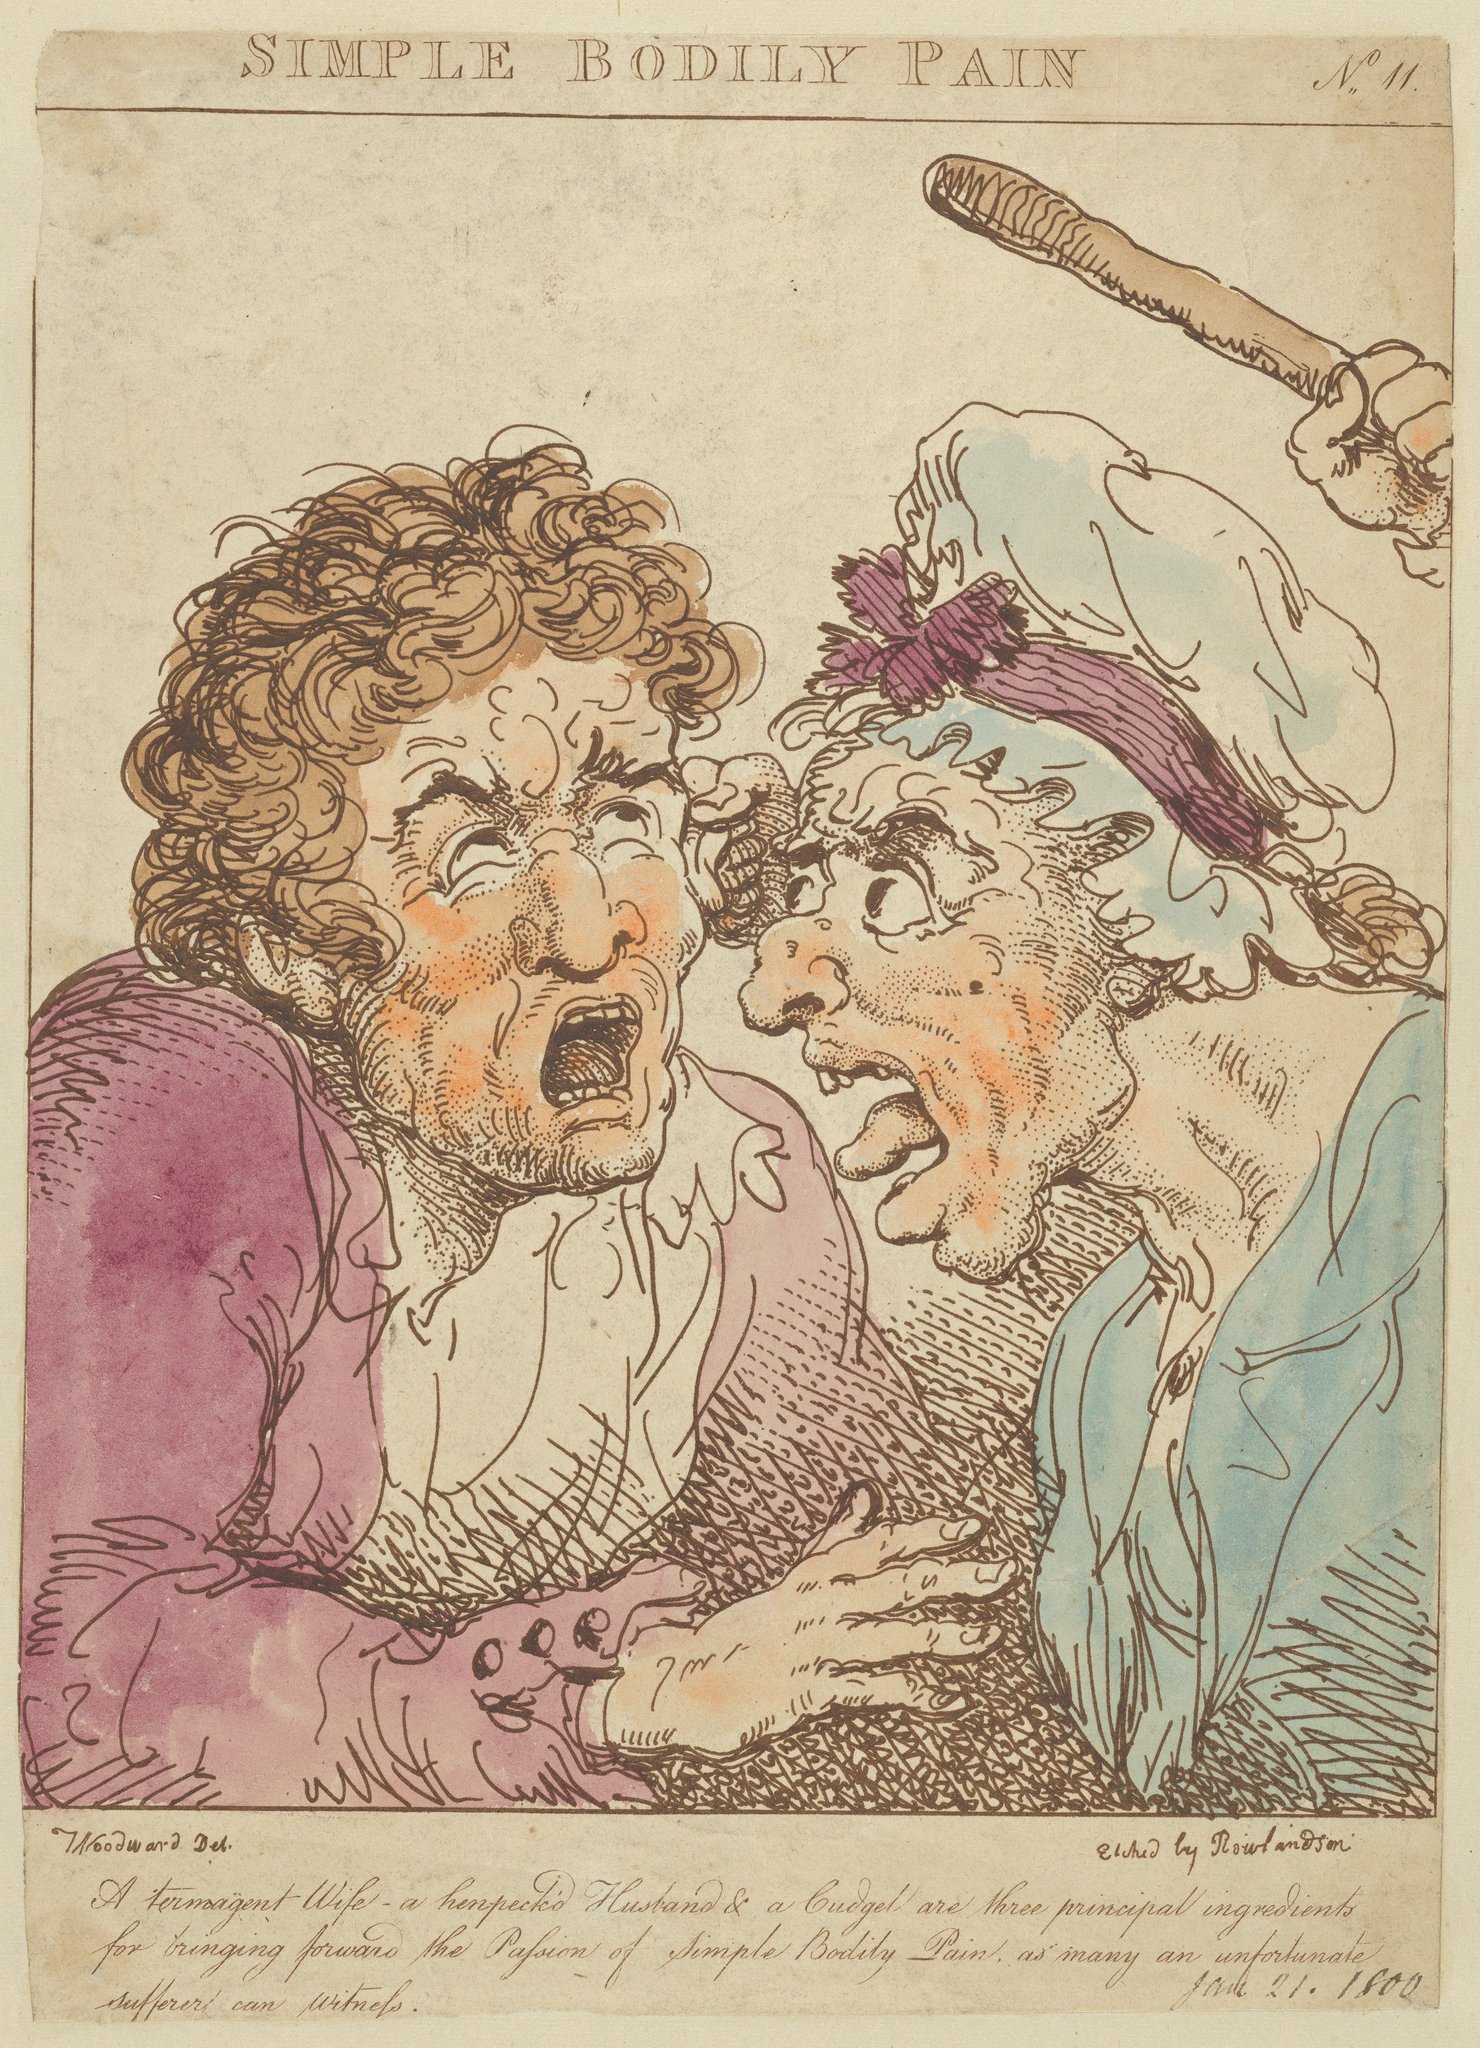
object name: print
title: Simple Bodily Pain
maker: thomas rowlandson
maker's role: artist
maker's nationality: british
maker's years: 1757-1827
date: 1800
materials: ink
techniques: etching, printing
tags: satire,men,women